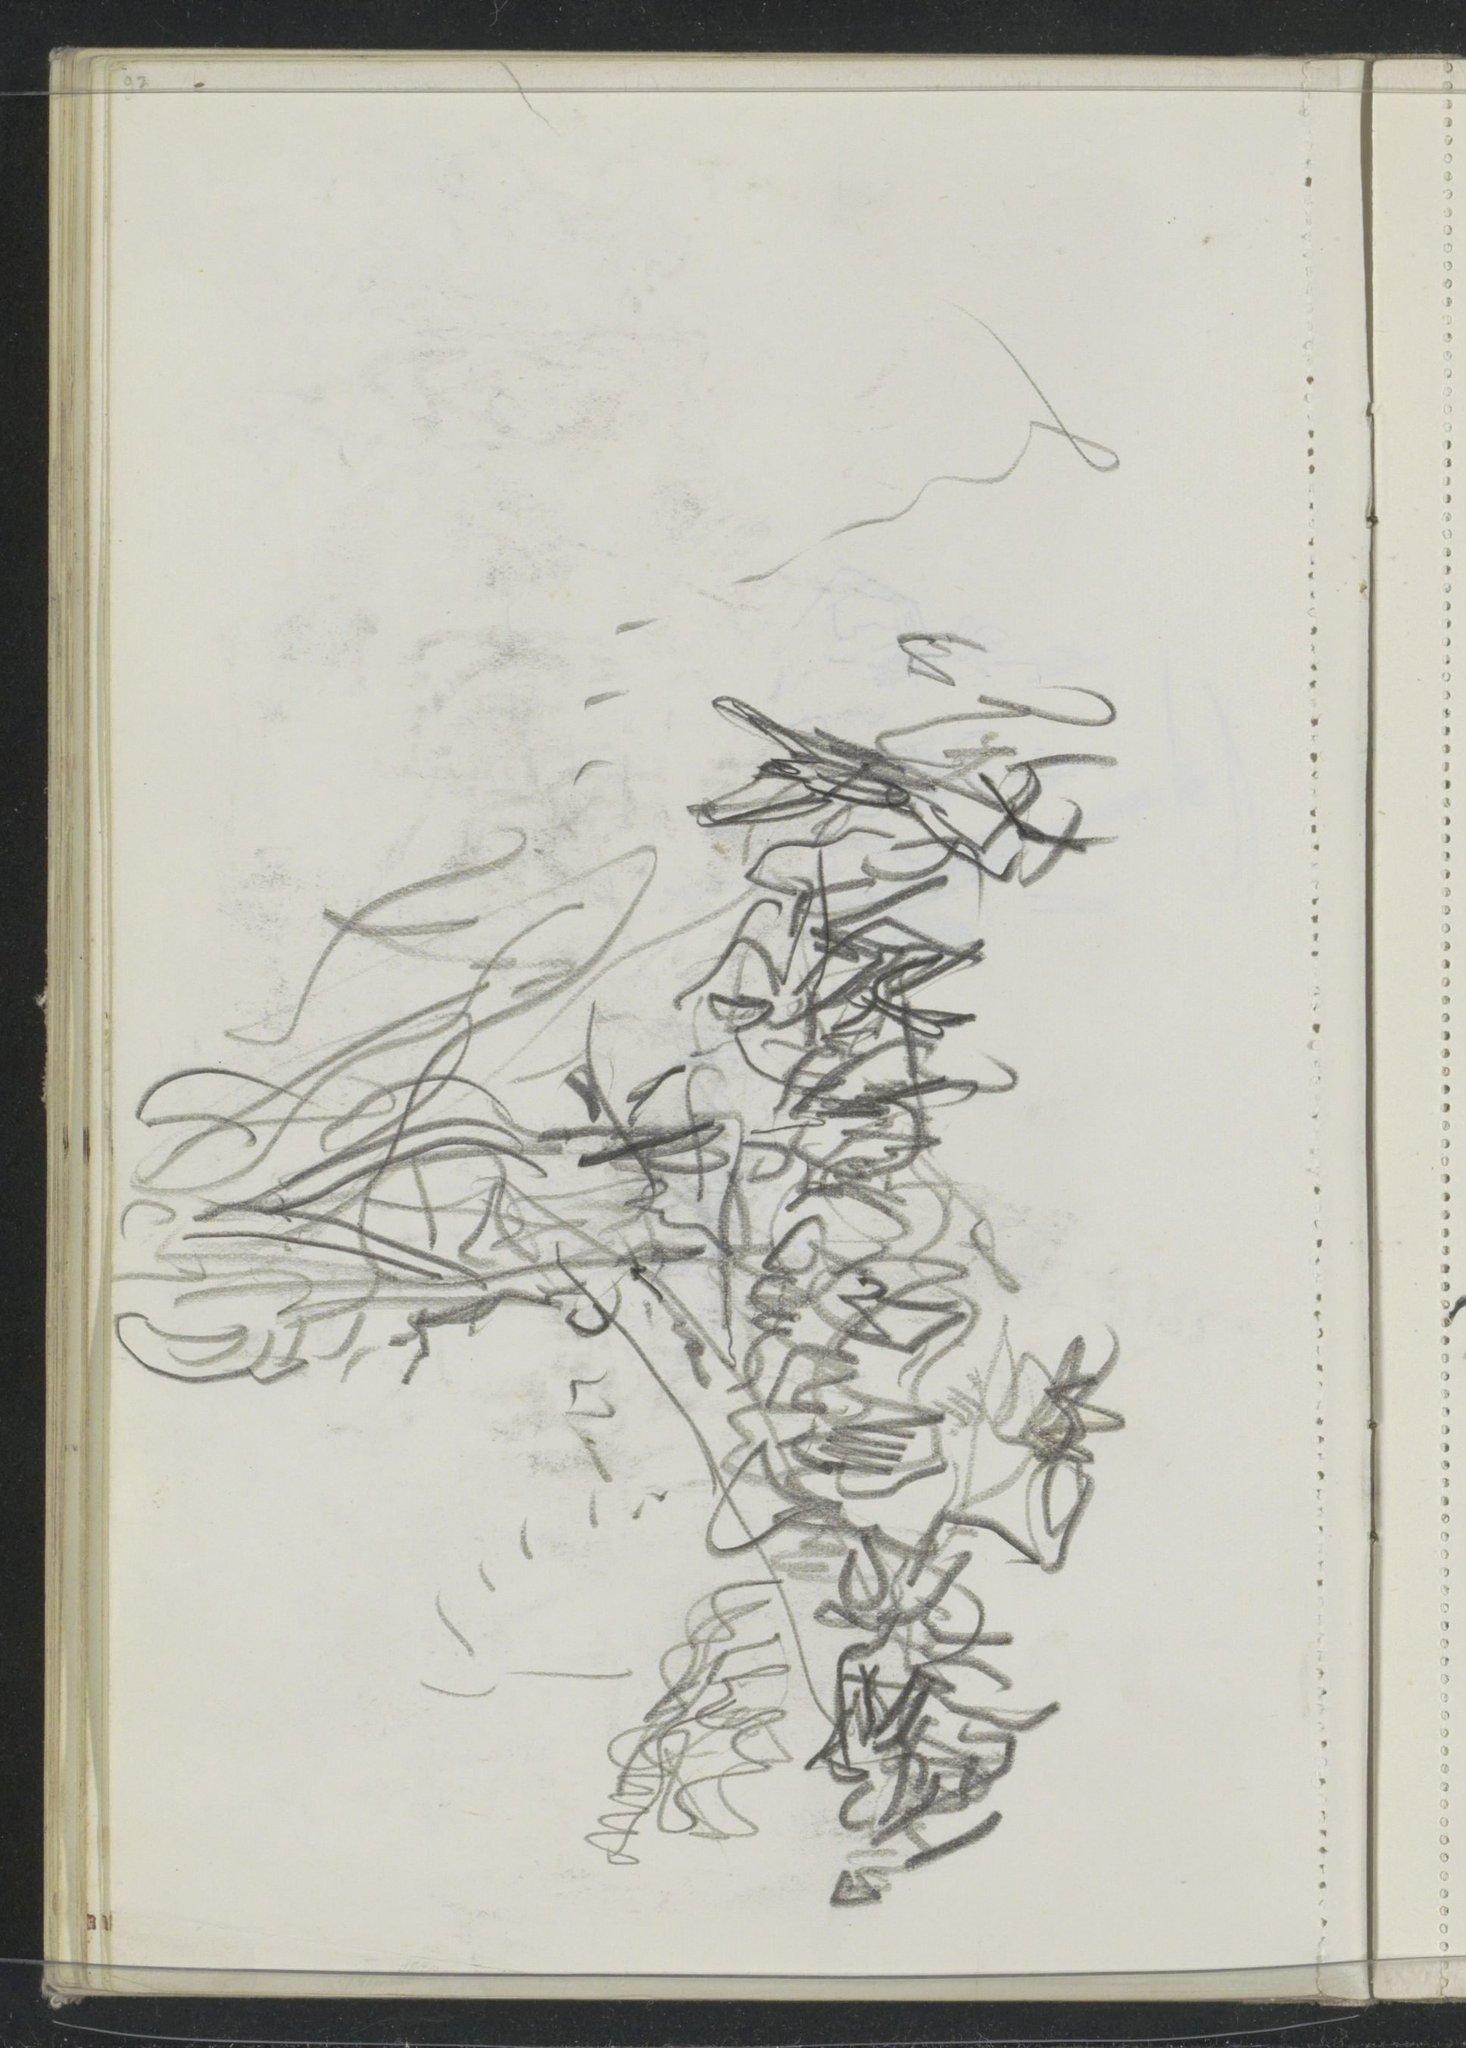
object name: sketchbook leaf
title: Optocht van figuren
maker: marius bauer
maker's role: draughtsman, print maker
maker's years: 1867-1932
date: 1925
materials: paper, pencil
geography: indonesia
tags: asiatic races and peoples, walking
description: Mogelijk duwen of trekken de figuren een beeld, lijkentoren of decoratiestuk mee in de optocht. Pagina 92 uit een schetsboek met 74 bladen.